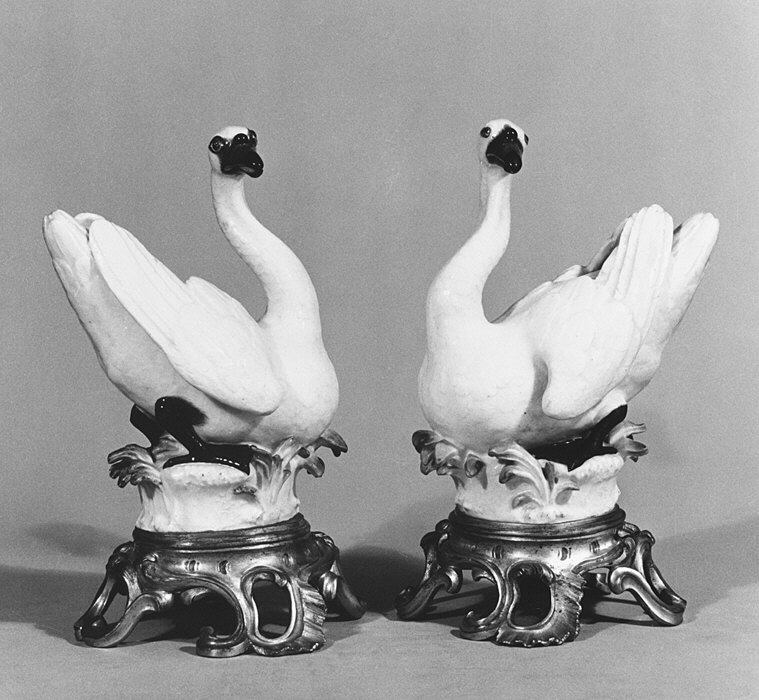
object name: figure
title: Swan (one of a pair)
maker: meissen manufactory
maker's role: manufactory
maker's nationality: german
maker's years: 1710-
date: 1748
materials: hard paste porcelain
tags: swans